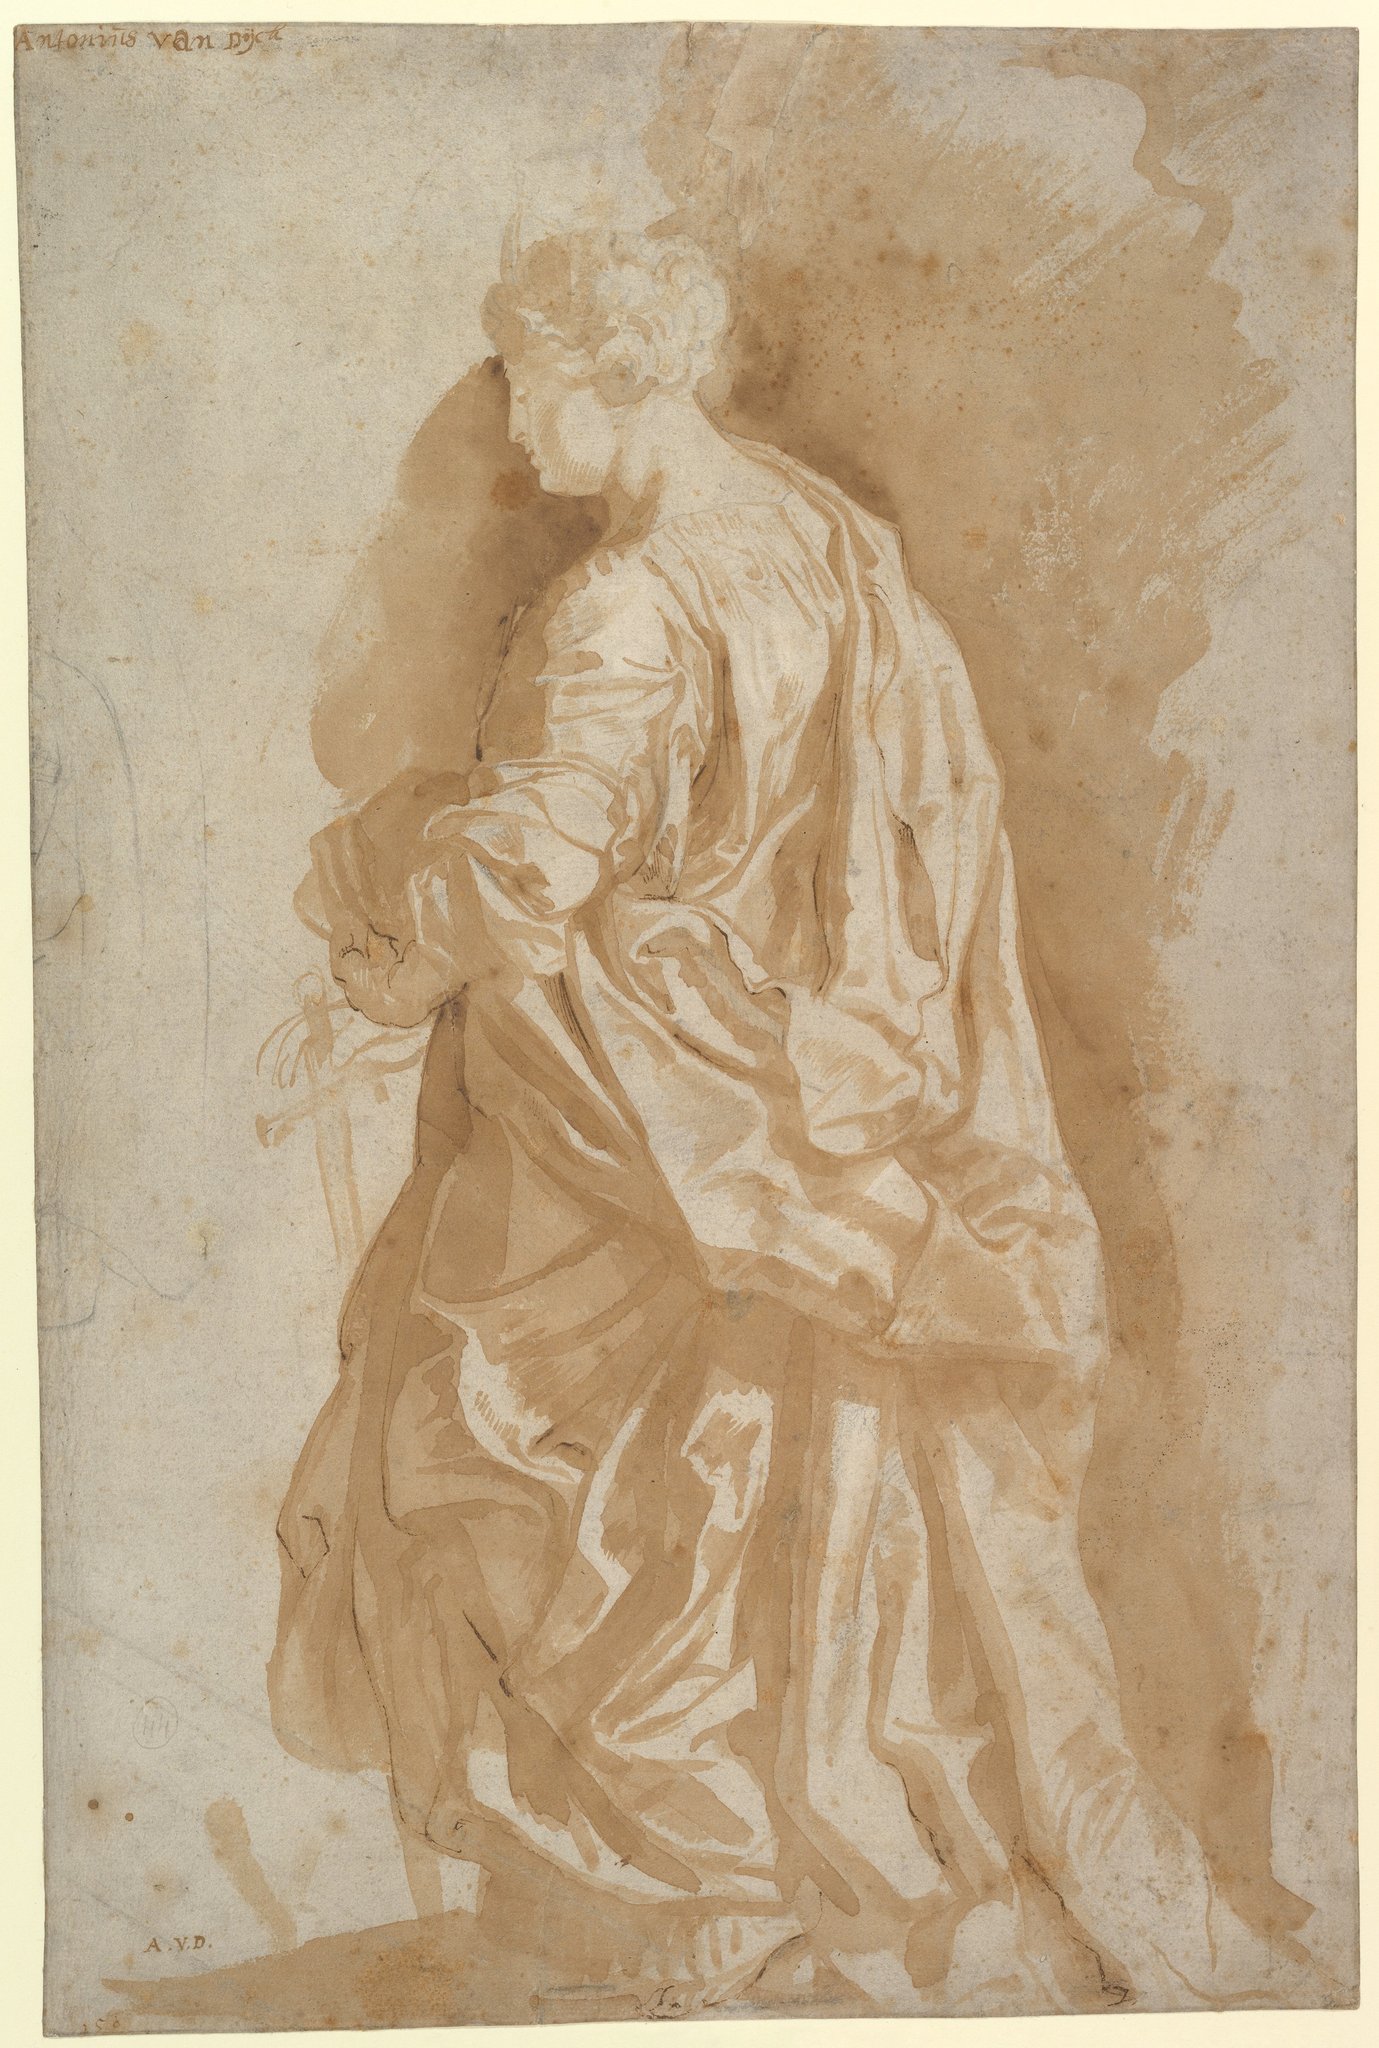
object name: drawing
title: Study of a Standing Female Saint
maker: peter paul rubens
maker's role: artist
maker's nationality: flemish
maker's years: 1577-1640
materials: chalk, ink, paper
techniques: brush, pen, wash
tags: women,saints